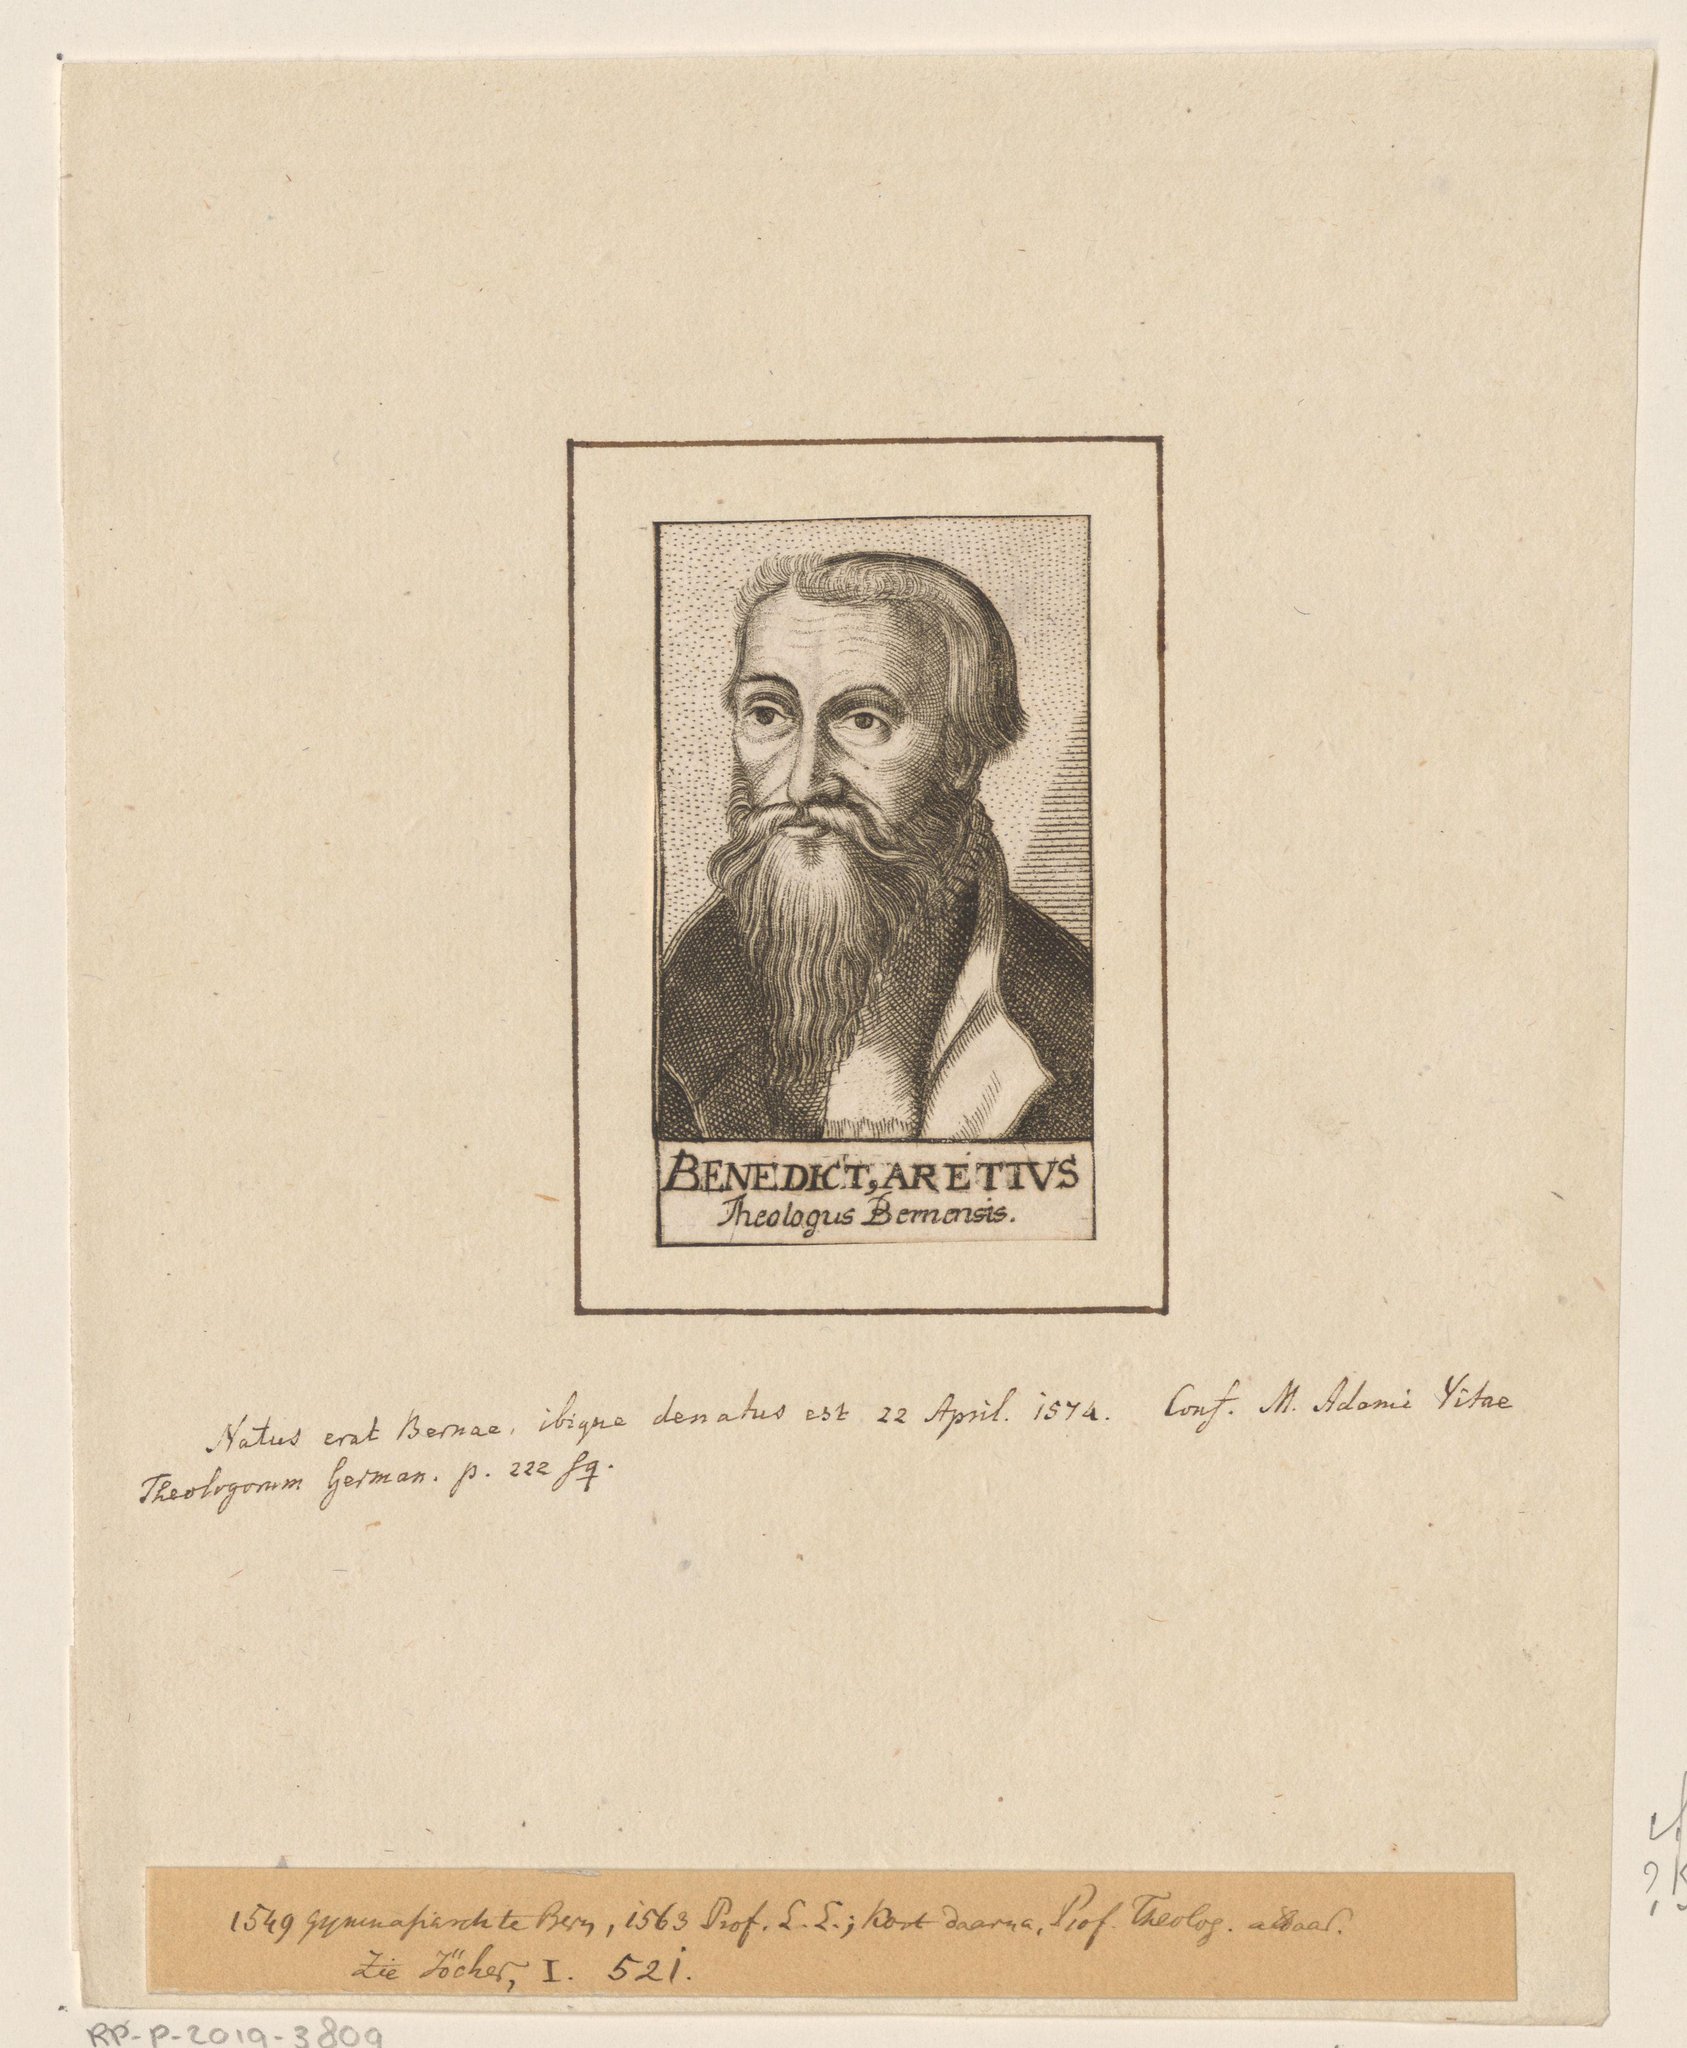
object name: print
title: Portret van Benedictus Aretius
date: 1688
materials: paper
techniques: engraving, etching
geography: nuremberg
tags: historical persons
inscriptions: inscription: ‘[...]’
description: Prent uit: Freher, Paul. Theatrum virorum eruditione clarorum. Neurenberg: Johann Hoffmann, 1688.